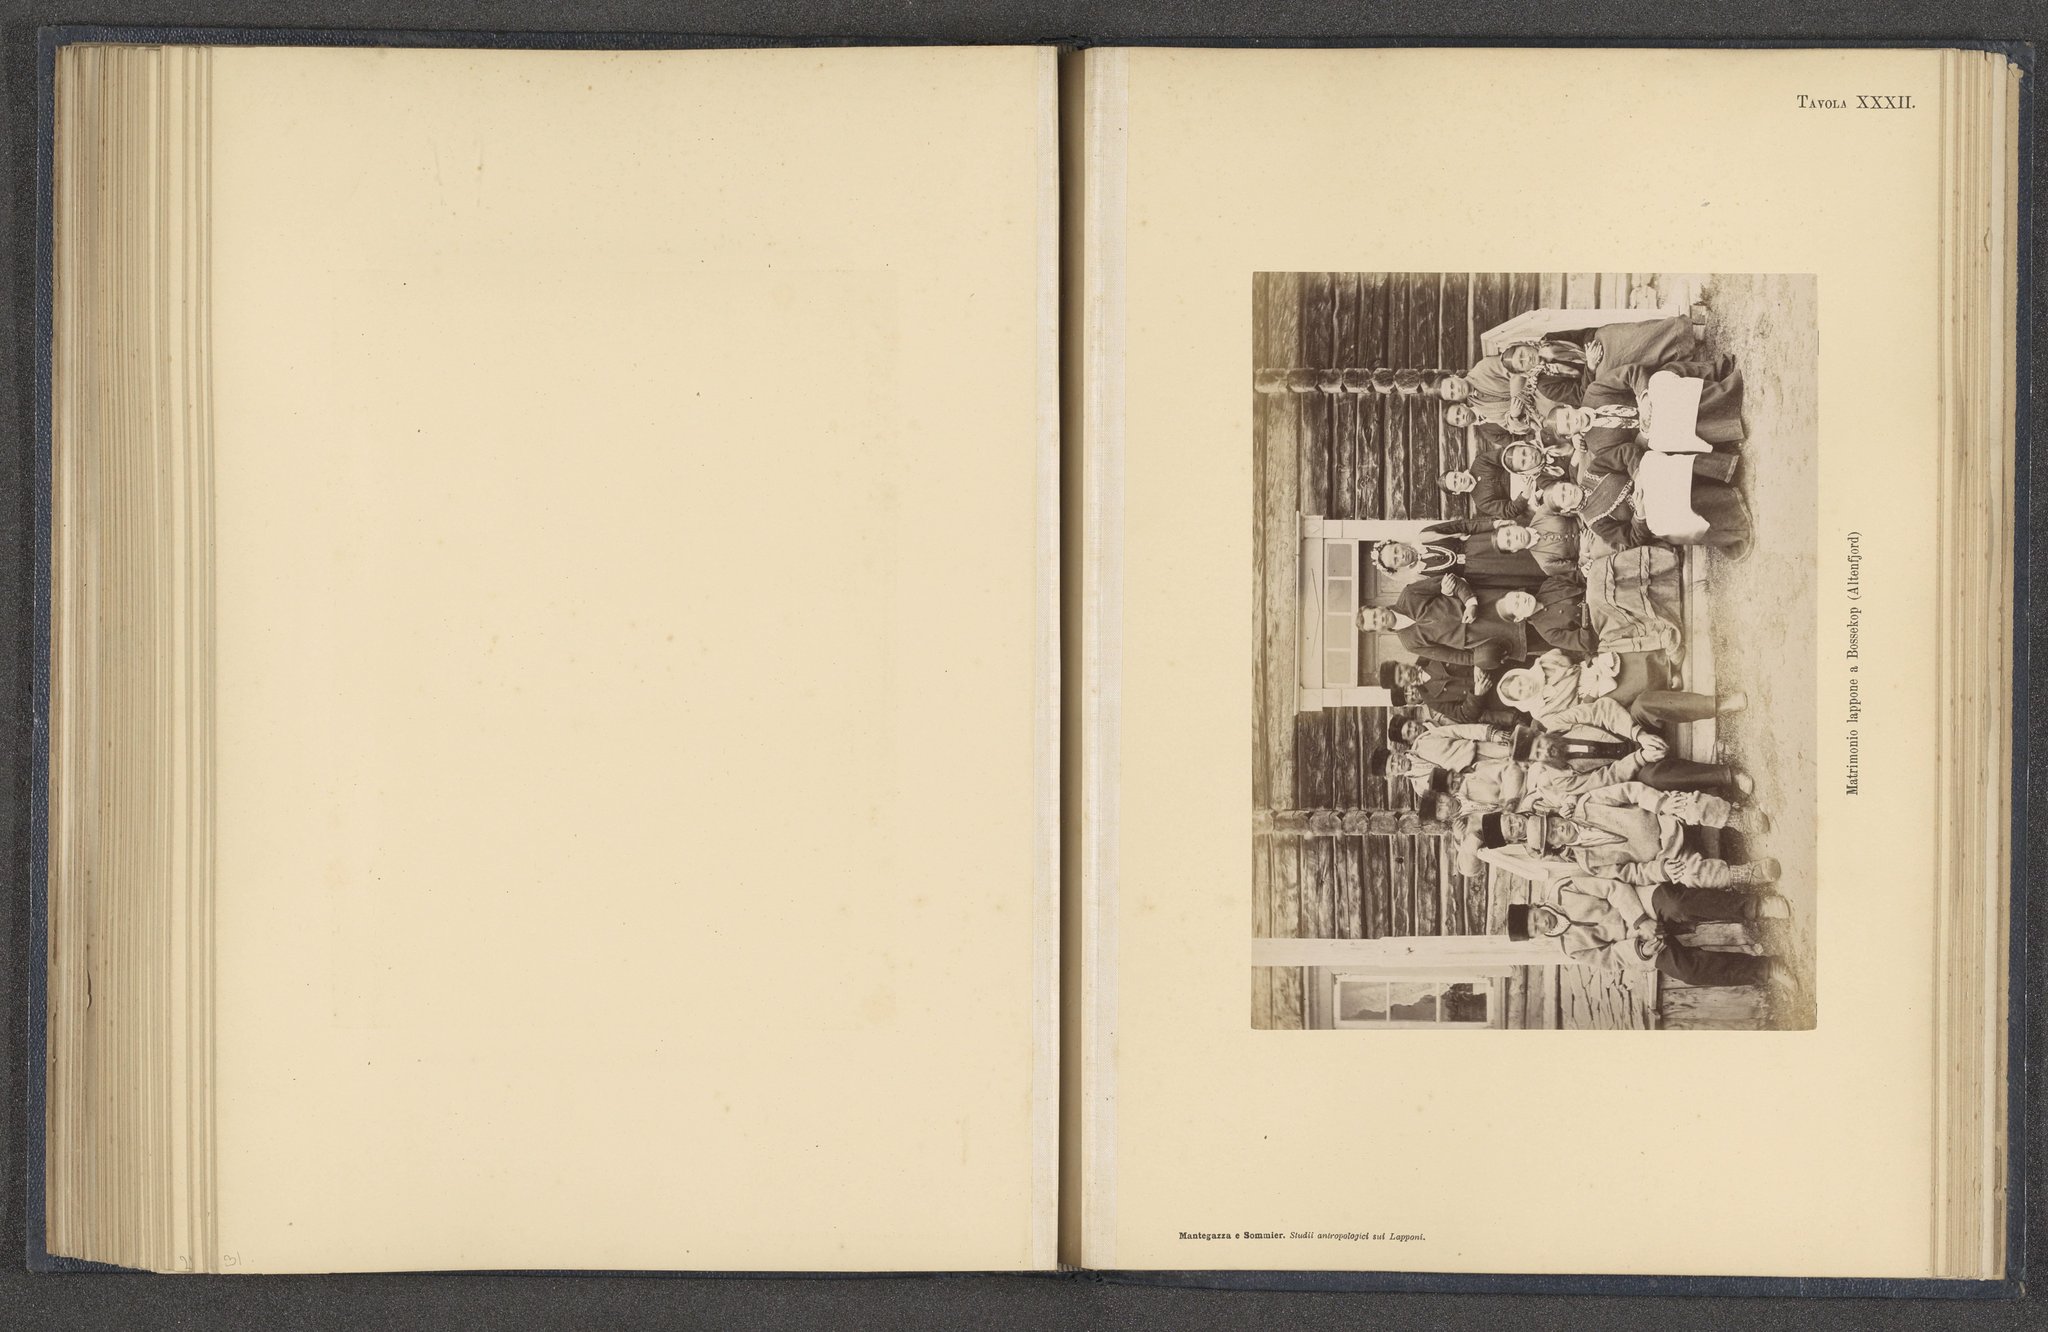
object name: page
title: Matrimonio lappone a Bossekop (Altenfjord)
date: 1870-1880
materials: photographic support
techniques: albumen print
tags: civil marriage ceremony, bride and groom in wedding-dress, anonymous historical persons portrayed in a group, in a group-portrait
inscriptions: number: ‘Tavola XXXII.’